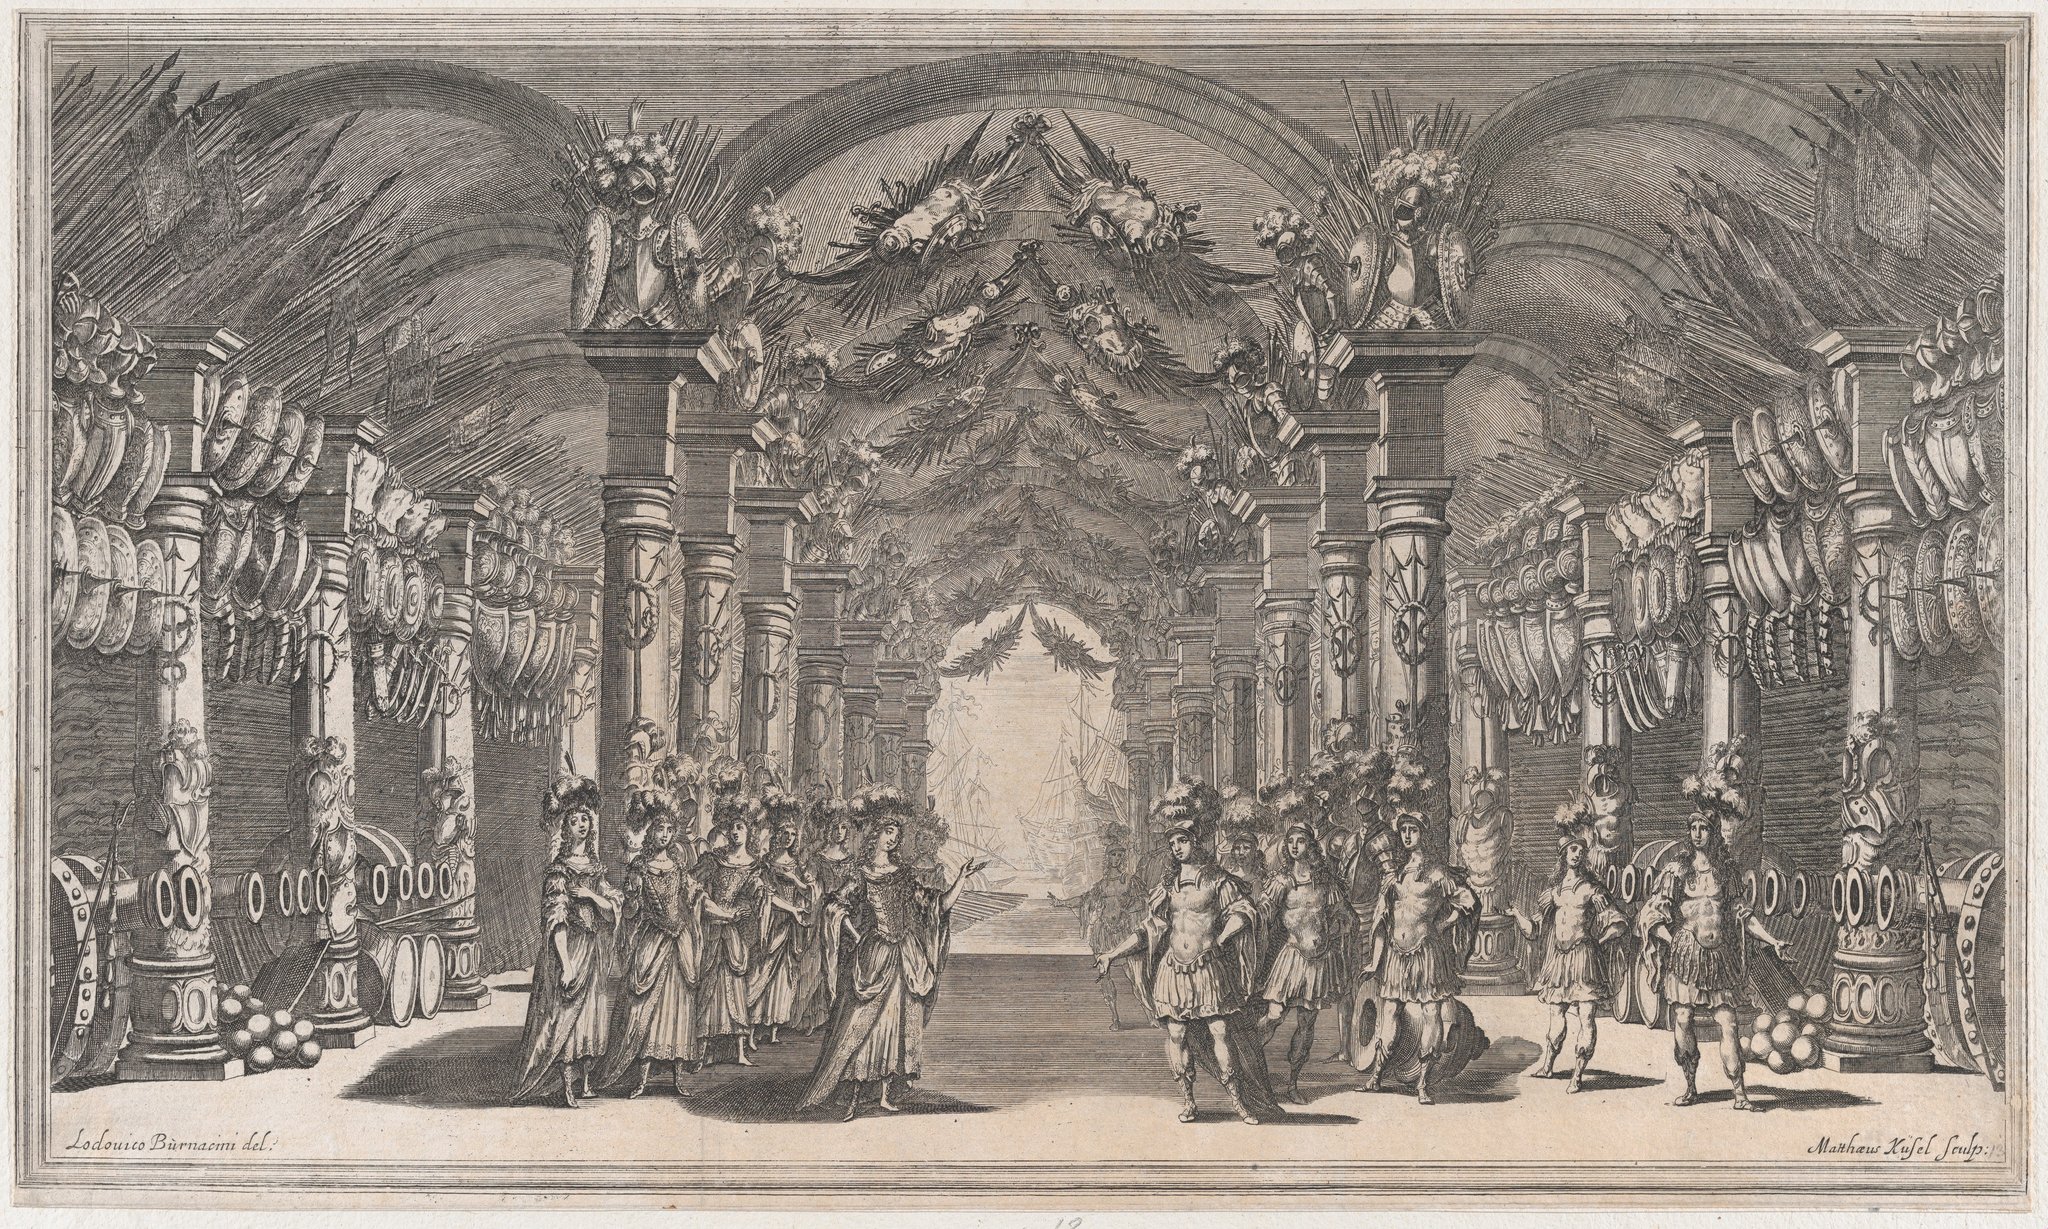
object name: print, fete, ornament architecture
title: Arsenal of Mars; a group of soldiers standing across from a group of women in an arsenal; ships off in the distance; set design from 'Il Pomo D'Oro'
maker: mathäus küsel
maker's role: artist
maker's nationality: german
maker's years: 1621-1682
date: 1668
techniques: etching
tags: opera,soldiers,men,women,mars,stage design